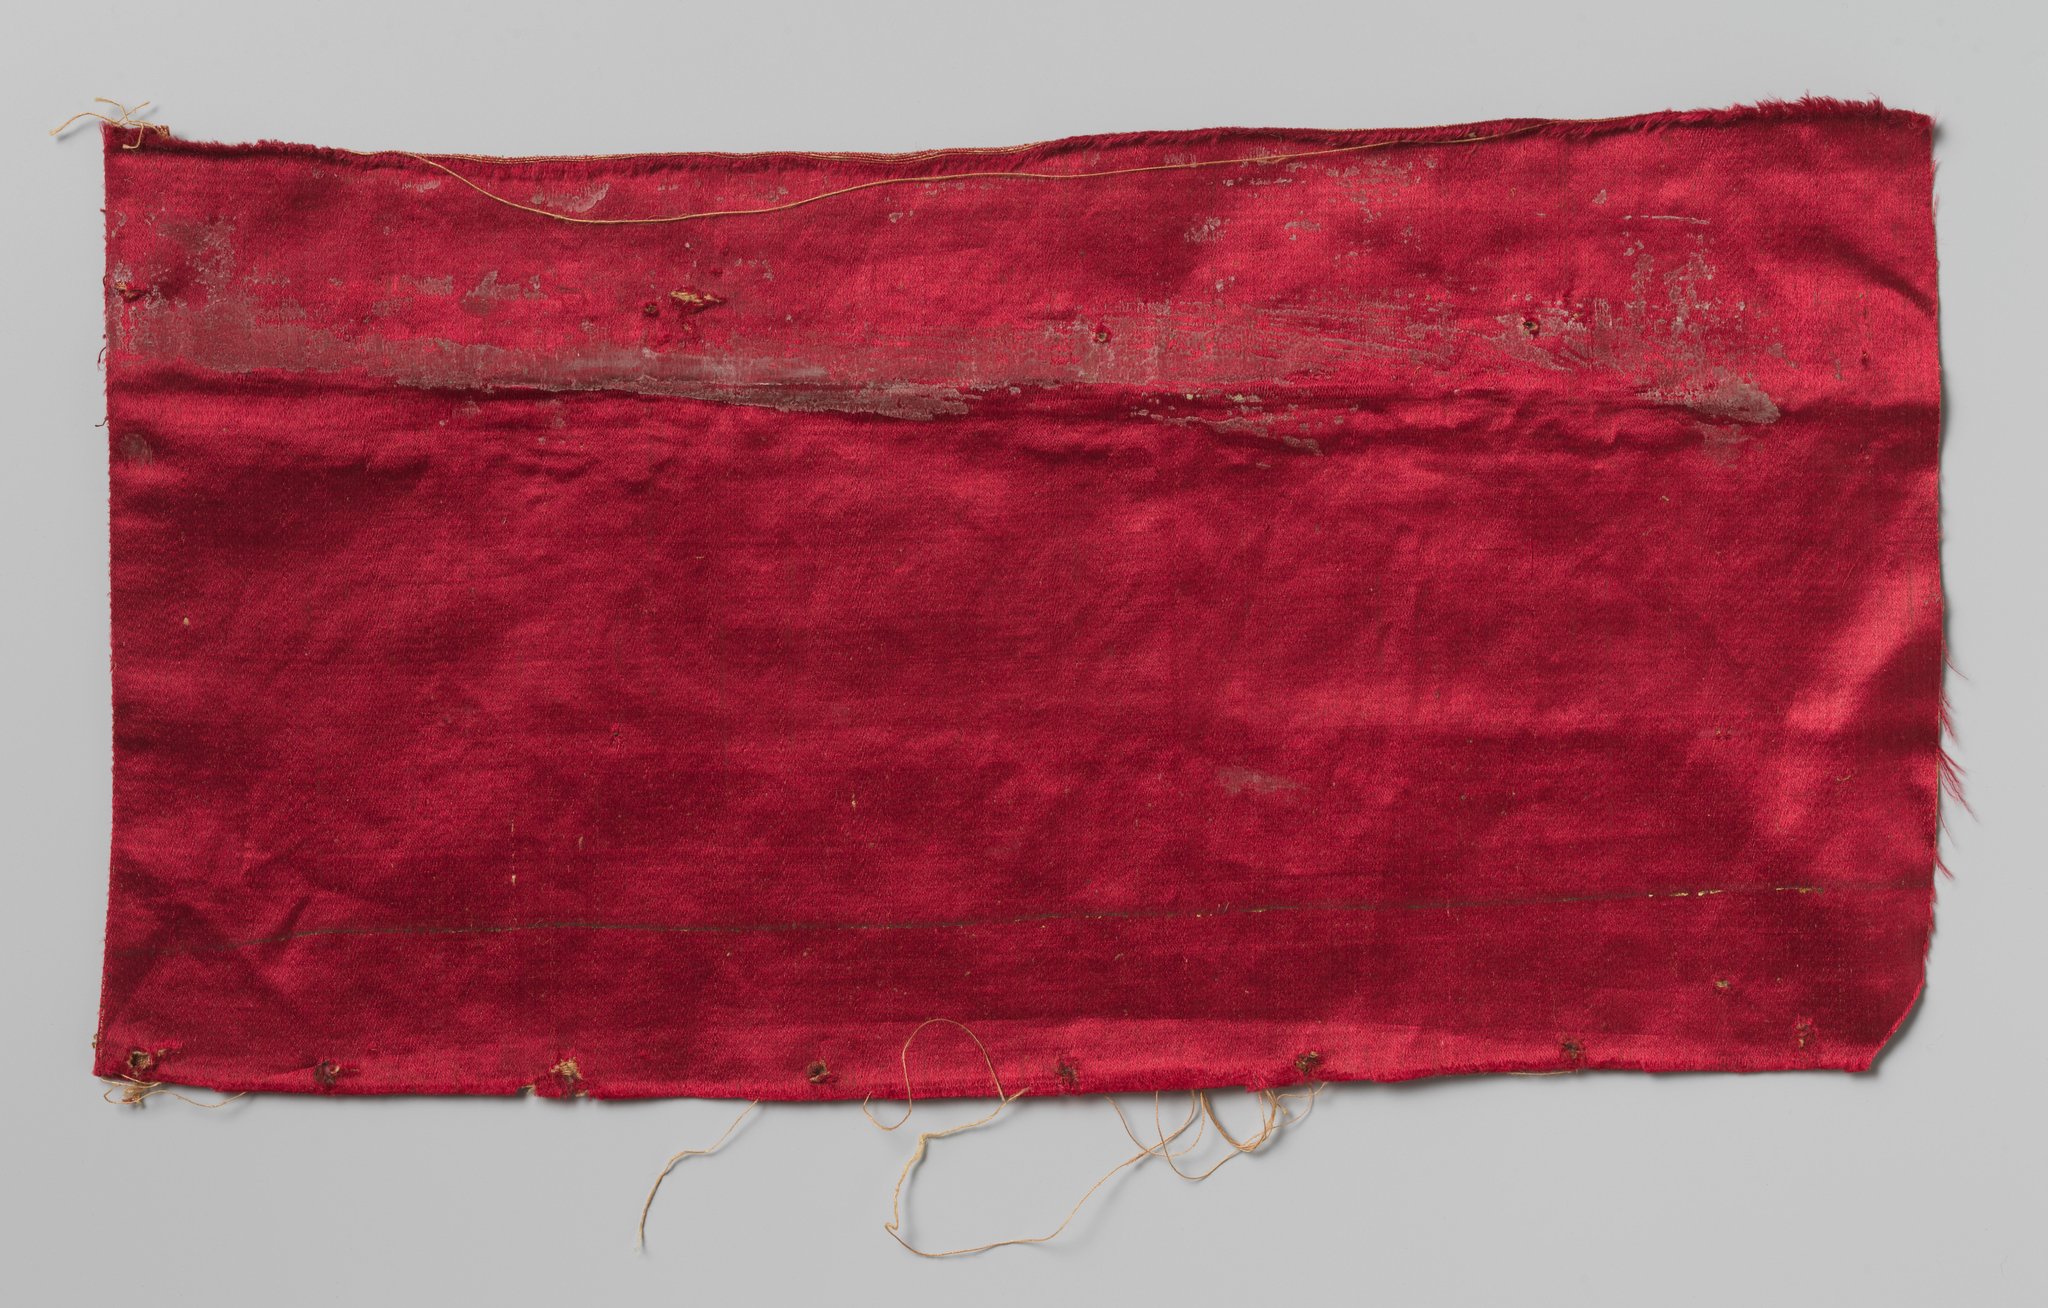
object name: upholstered wall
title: Fragment van wandbespanning van ceriserode satijn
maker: Anonymous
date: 1600-1699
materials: textile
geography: france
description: Fragment van wandbespanning van ceriserode satijn. Maakt deel uit van een groep van 26,5 onderdelen. Gaten in het object (spijkergaten) en vlekken (waarschijnlijk lijmresten)